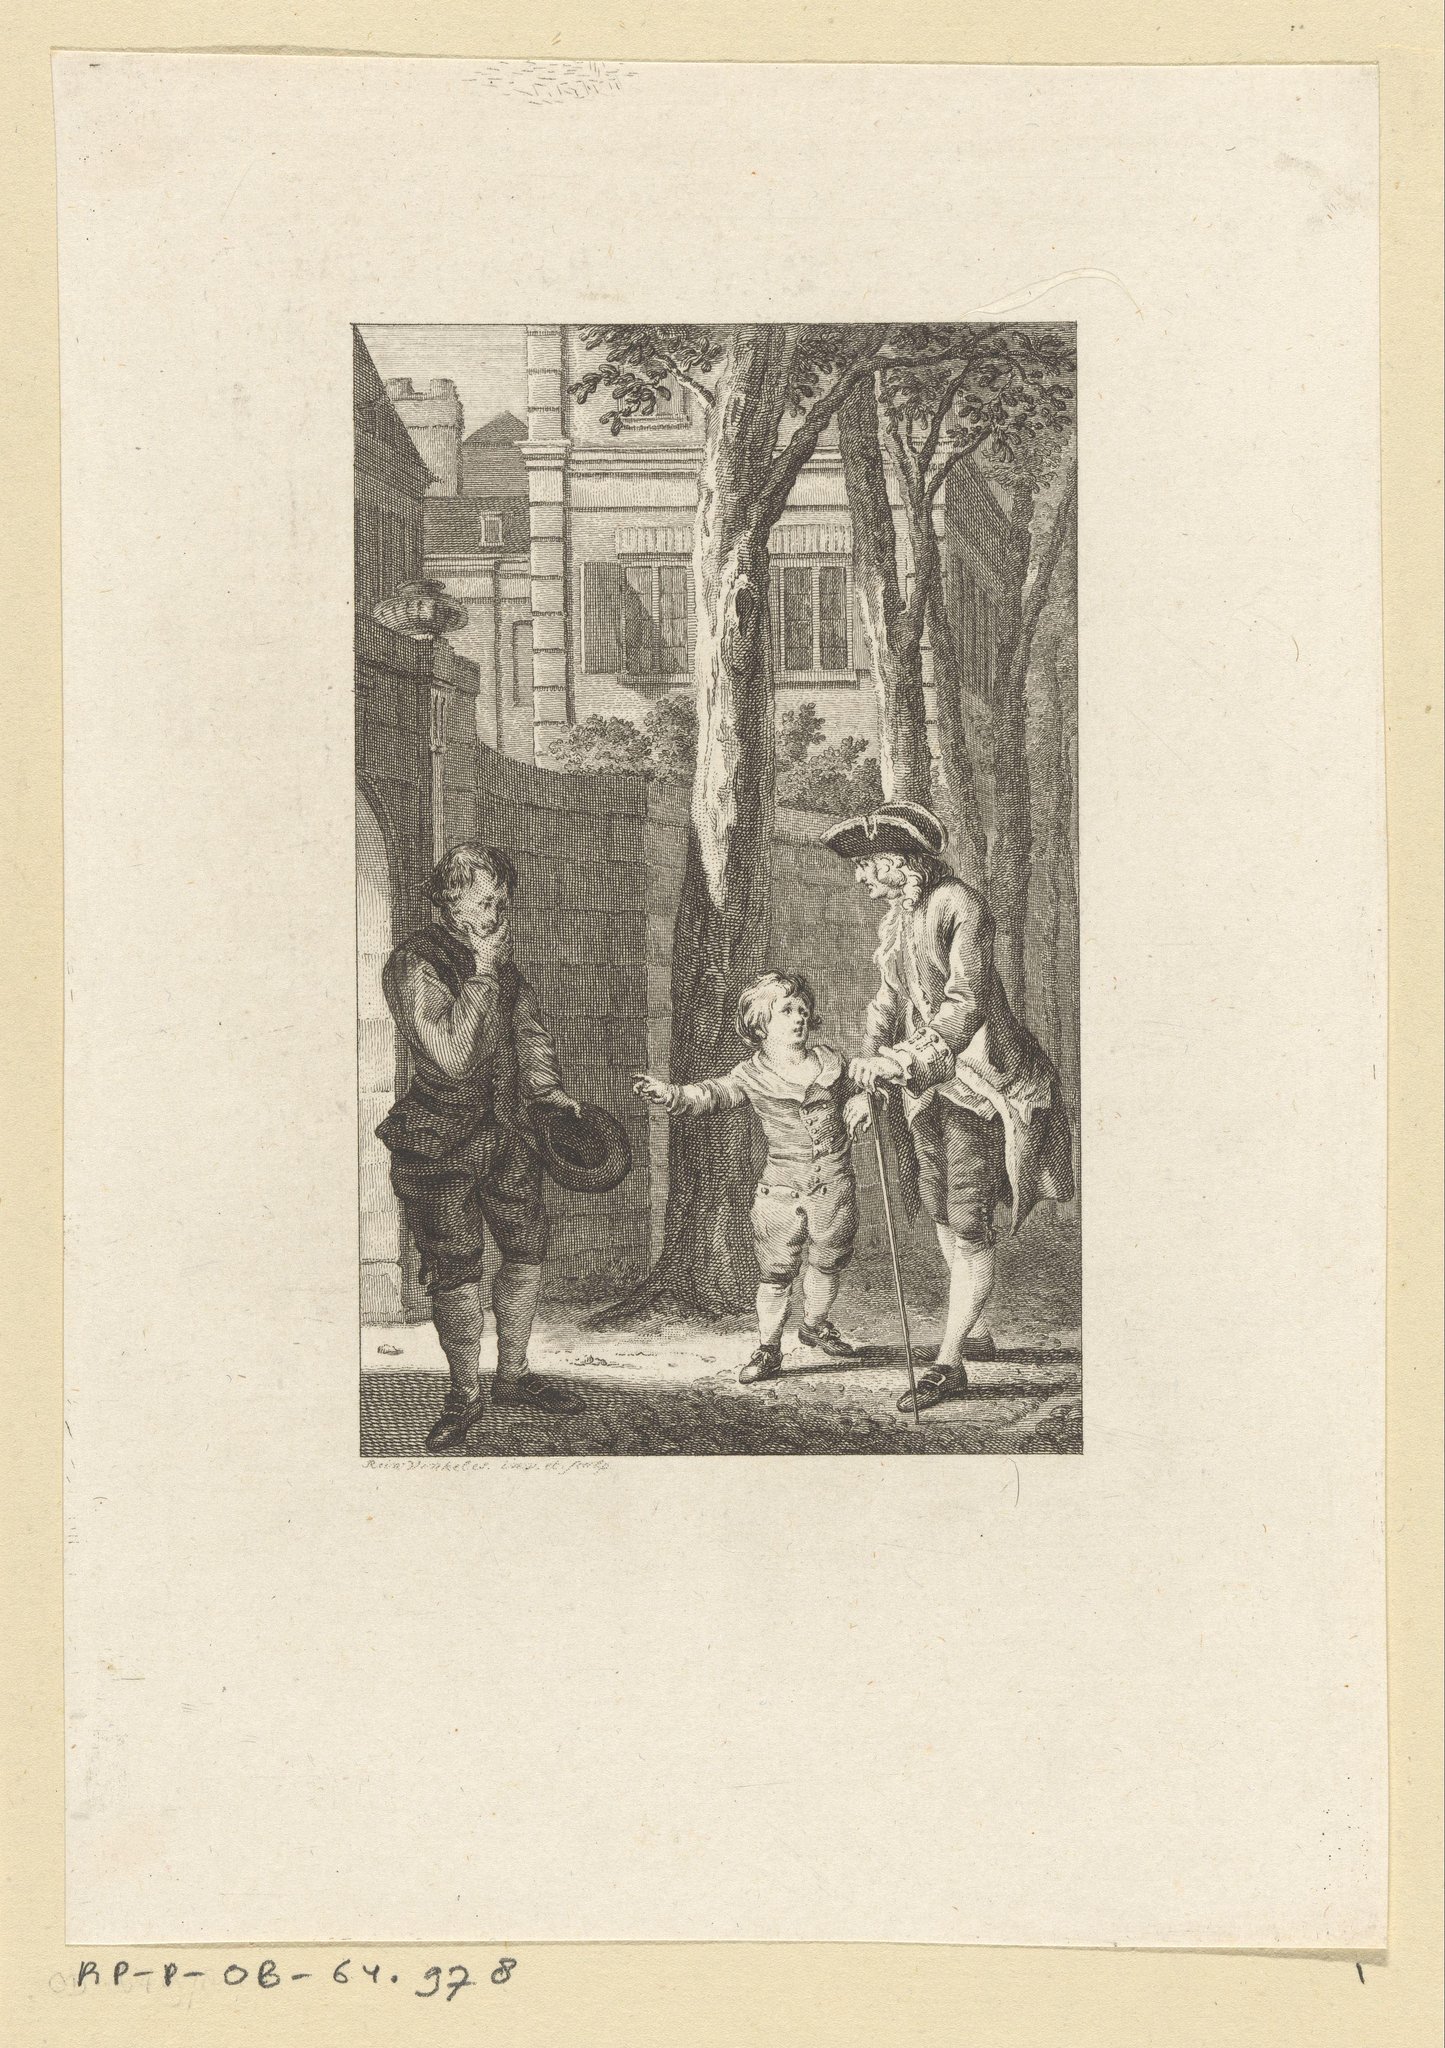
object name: print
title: Jongen wijst een heer op een bedelaar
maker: reinier vinkeles (i)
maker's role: draughtsman, print maker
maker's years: 1741-1816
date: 1786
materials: paper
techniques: engraving, etching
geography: amsterdam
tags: gate, entrance, beggar, index finger forwards, pointing, indicating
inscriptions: collector's mark: Lugt 240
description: Proefdruk van een prent die ook gebruikt is als illustratie bij het verhaal 'Valmiers' voor: Baculard d'Arnaud, F.T.M. de. Zedelijke verhaalen, deel 10. Amsterdam: A. Mens Jansz., 1786.